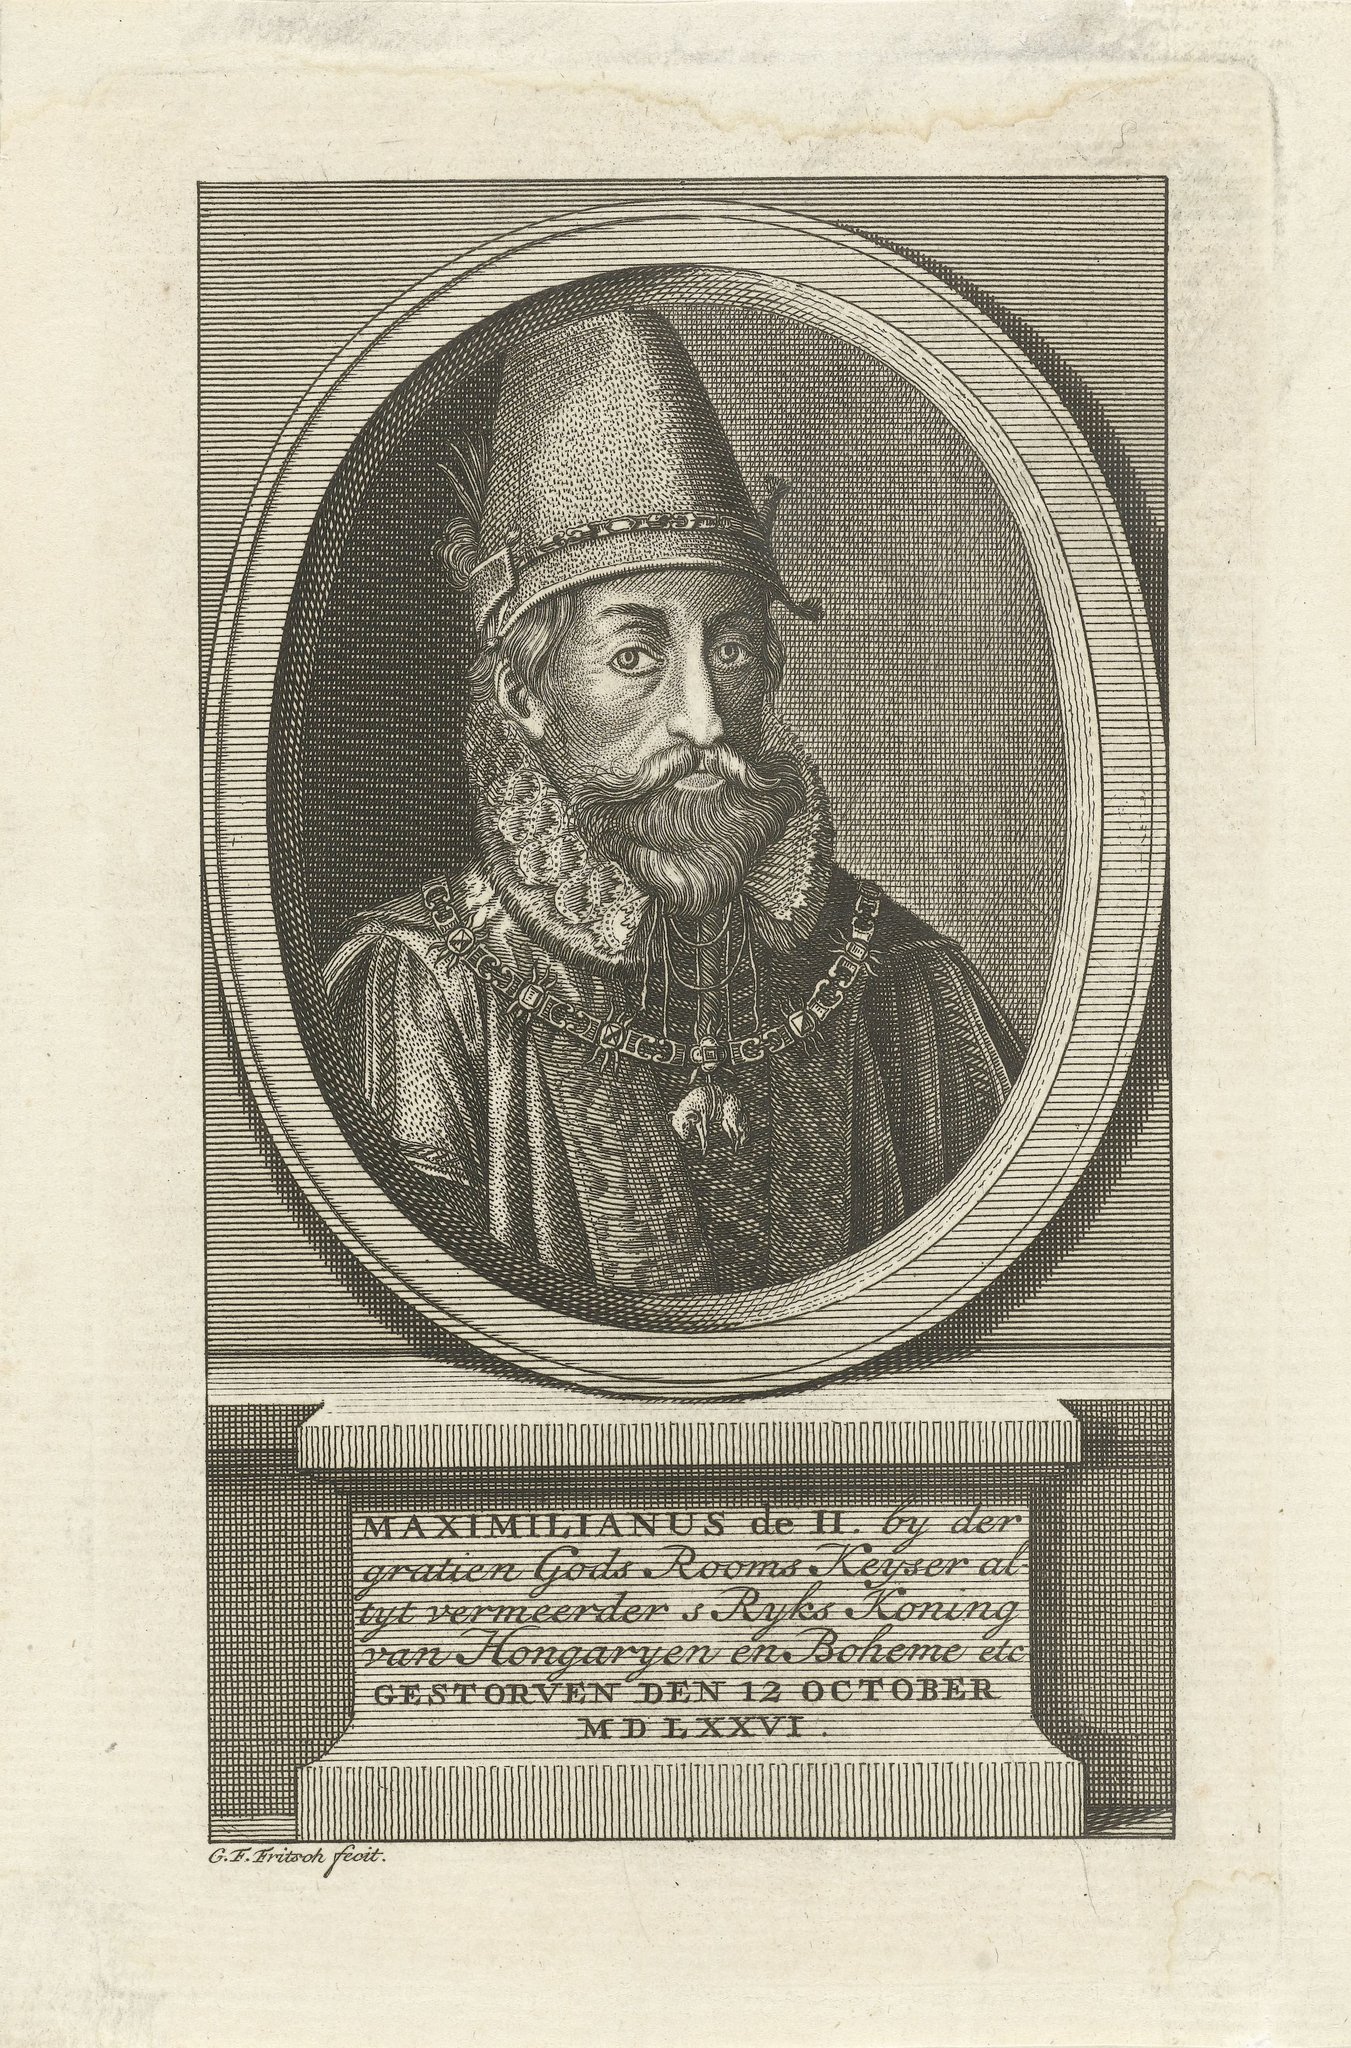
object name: print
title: Portret van keizer Maximiliaan II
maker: christian friedrich fritzsch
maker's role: print maker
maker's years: 1719-1774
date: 1753-1774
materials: paper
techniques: etching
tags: vienna, maximiliaan ii (keizer van heilige roomse rijk), knighthood order of the golden fleece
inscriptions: collector's mark: Lugt 2228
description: Portret opgenomen in: Meteren, Emanuel van. Historie van de oorlogen en geschiedenissen der Nederlanderen, en der zelver Naburen: beginnende met den Jare 1315, en eindigende met den Jare 1611, deel 2 van 10. Amsterdam: Steven Jacobus Baalde, 1786.